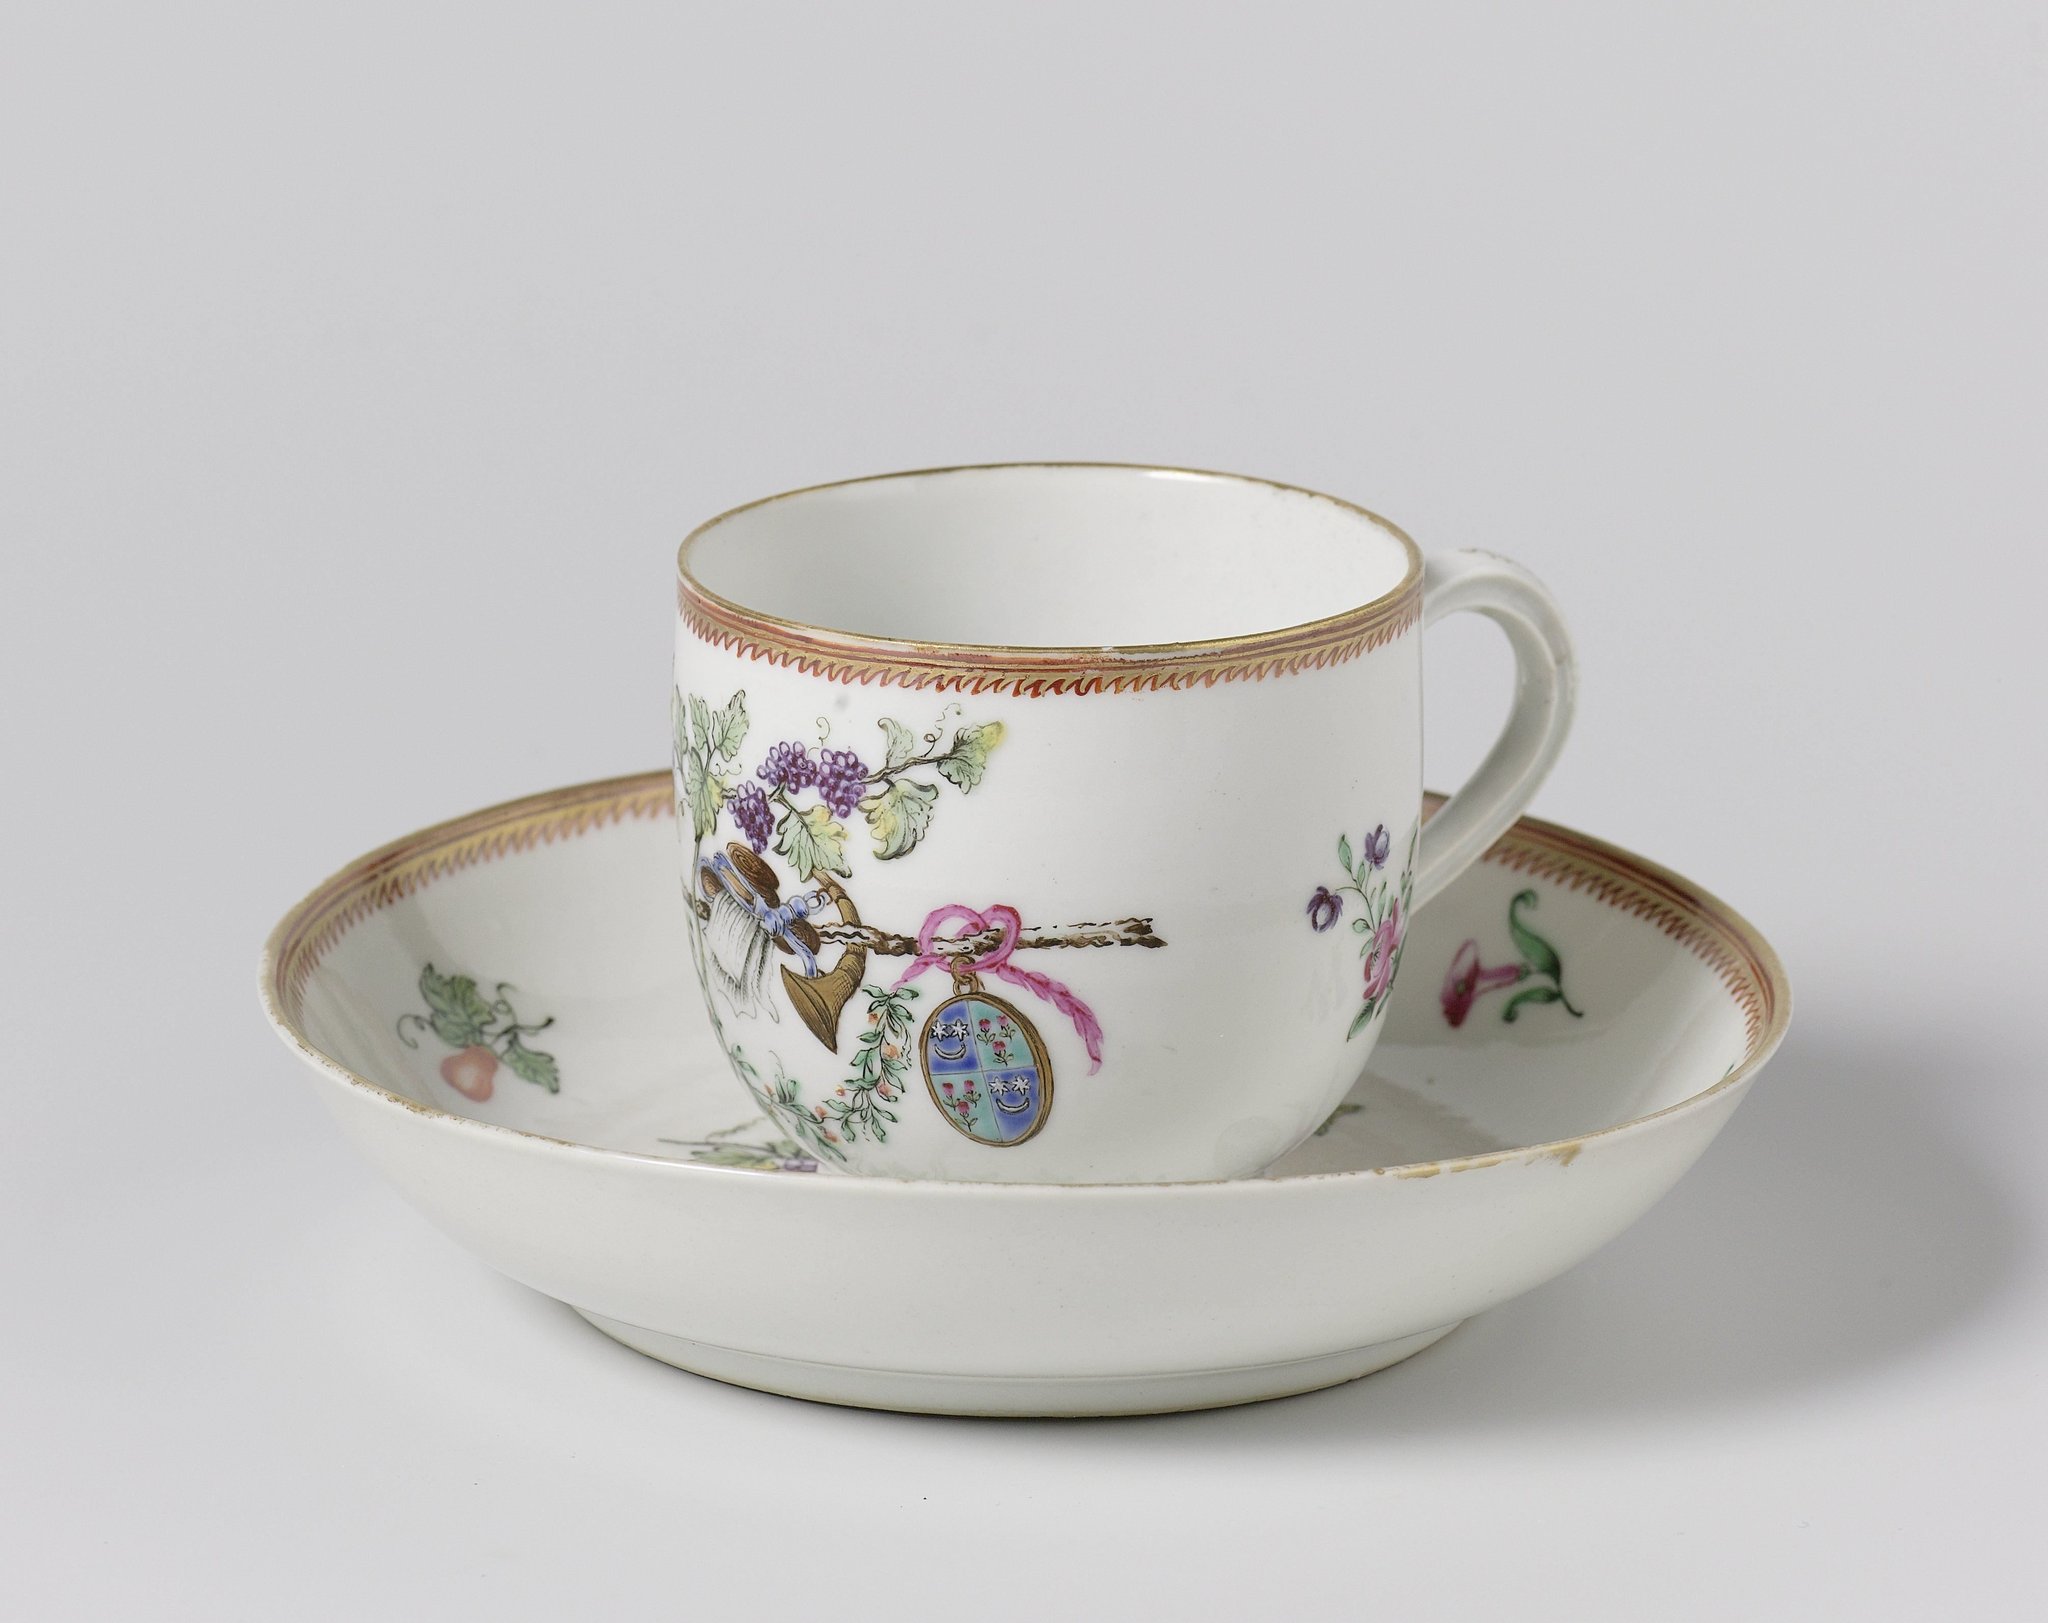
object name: kop en schotel, kop en schotel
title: Cup with handle and saucer with the arms of the Visvliet and Sluymer families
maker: Anonymous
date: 1777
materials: glaze, gold, paint, porcelain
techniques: firing, gilding, turning, vitrification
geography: china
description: Kop en schotel van porselein. Versierd met bloem- en vruchtentakken en een stok waaraan een hoed, een blad papier een hoorn en 2 wapenschilden zijn bevestigd. De wapens zijn van de families Visvliet en Sluymer (uit Zeeland).